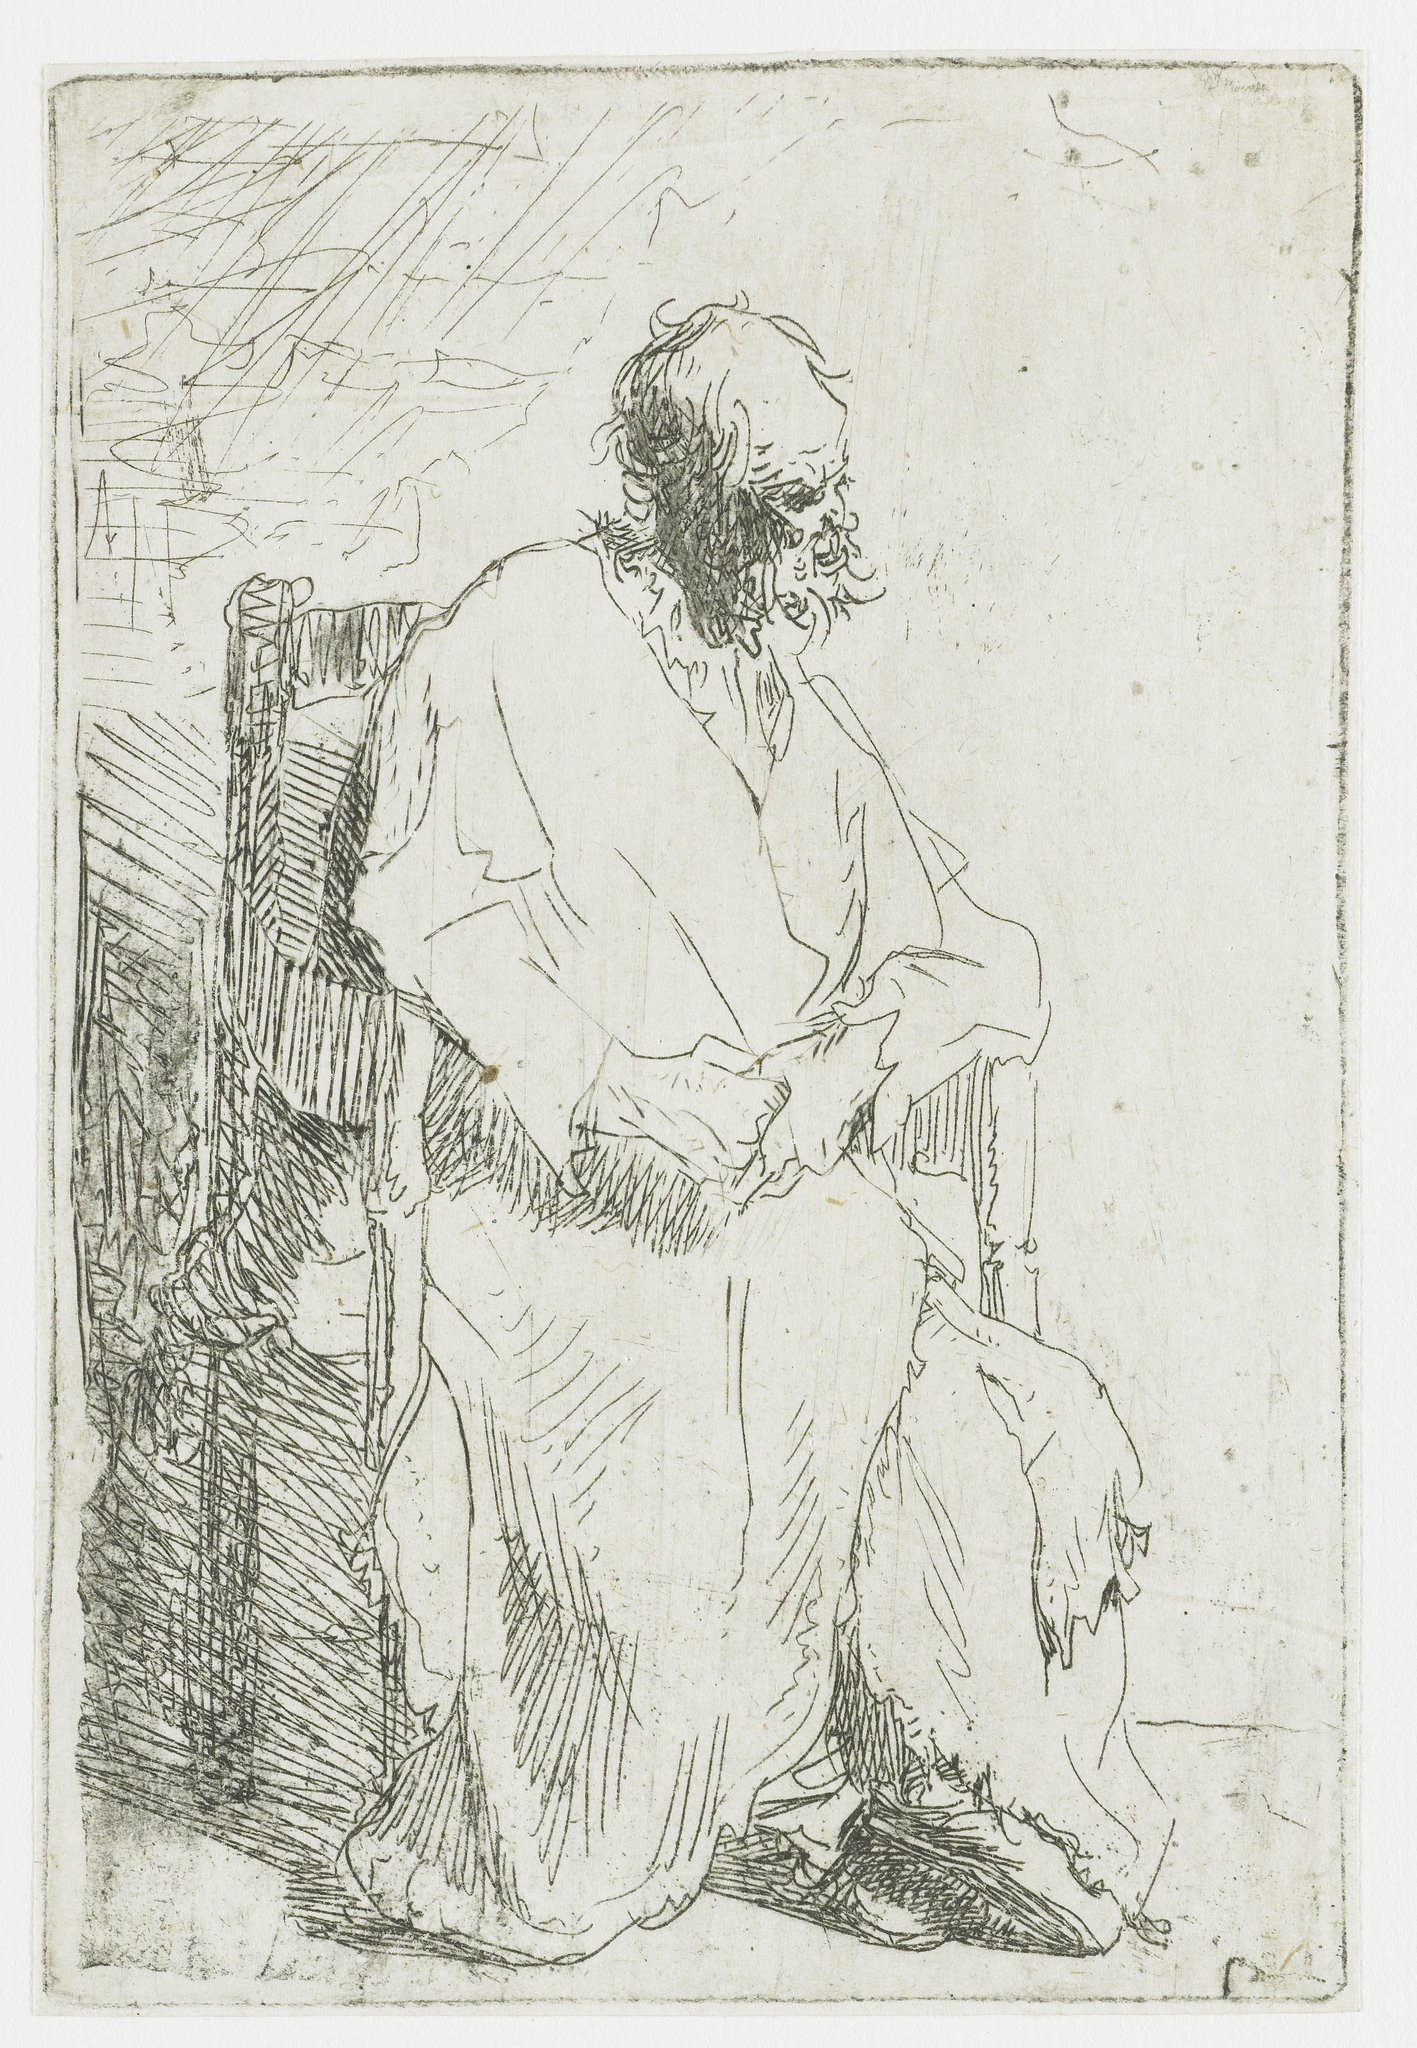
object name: print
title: Beggar in a long cloak sitting in an armchair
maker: rembrandt van rijn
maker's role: draughtsman, painter, print maker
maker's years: 1606-1669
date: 1629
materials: paper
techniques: etching, intaglio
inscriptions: collector's mark: Lugt 240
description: The numerous old men that Rembrandt etched in his early years in Leiden will have regularly posed for him while seated in a chair. This is rarely visible in his prints, but is so in this one. The shabbily attired old man with a patchy beard and bony hands stands out slightly against the large armchair in which he sits. This chair lends him an air of near biblical grandeur.